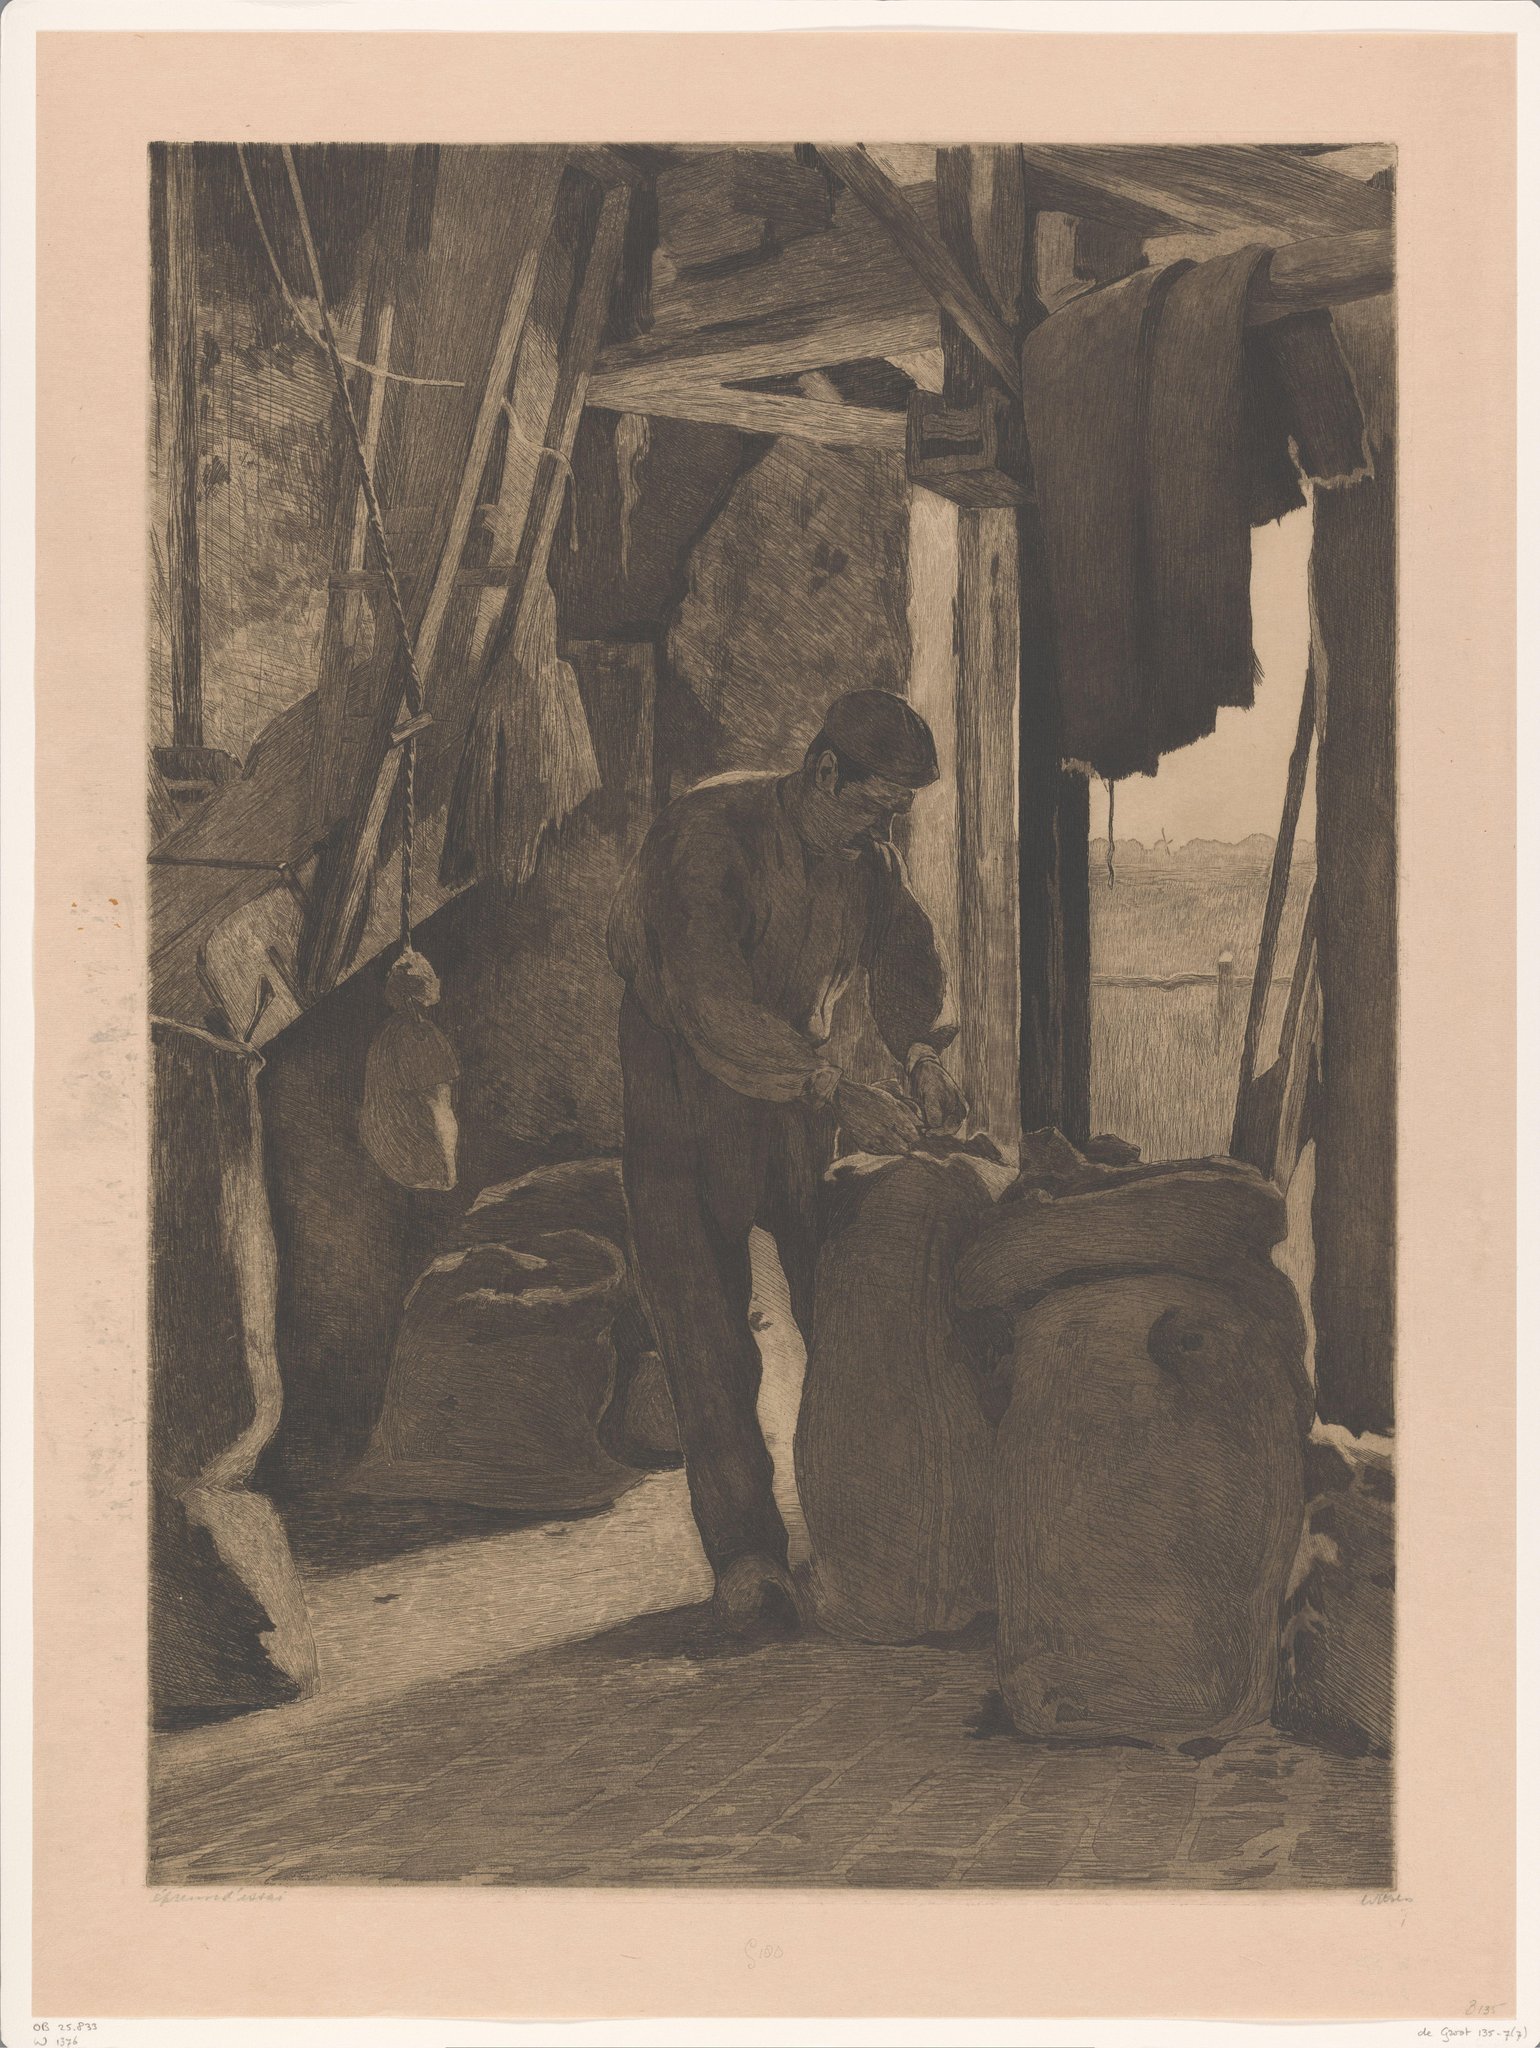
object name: print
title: Molenaar in de korenmolen van Wijk bij Duurstede knoopt een zak dicht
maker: willem witsen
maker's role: draughtsman, painter, print maker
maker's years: 1860-1923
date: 1908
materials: paper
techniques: aquatint, etching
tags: miller, windmill (+ men (labourers)), wijk bij duurstede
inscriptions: annotation: ‘épreuve d'essai’